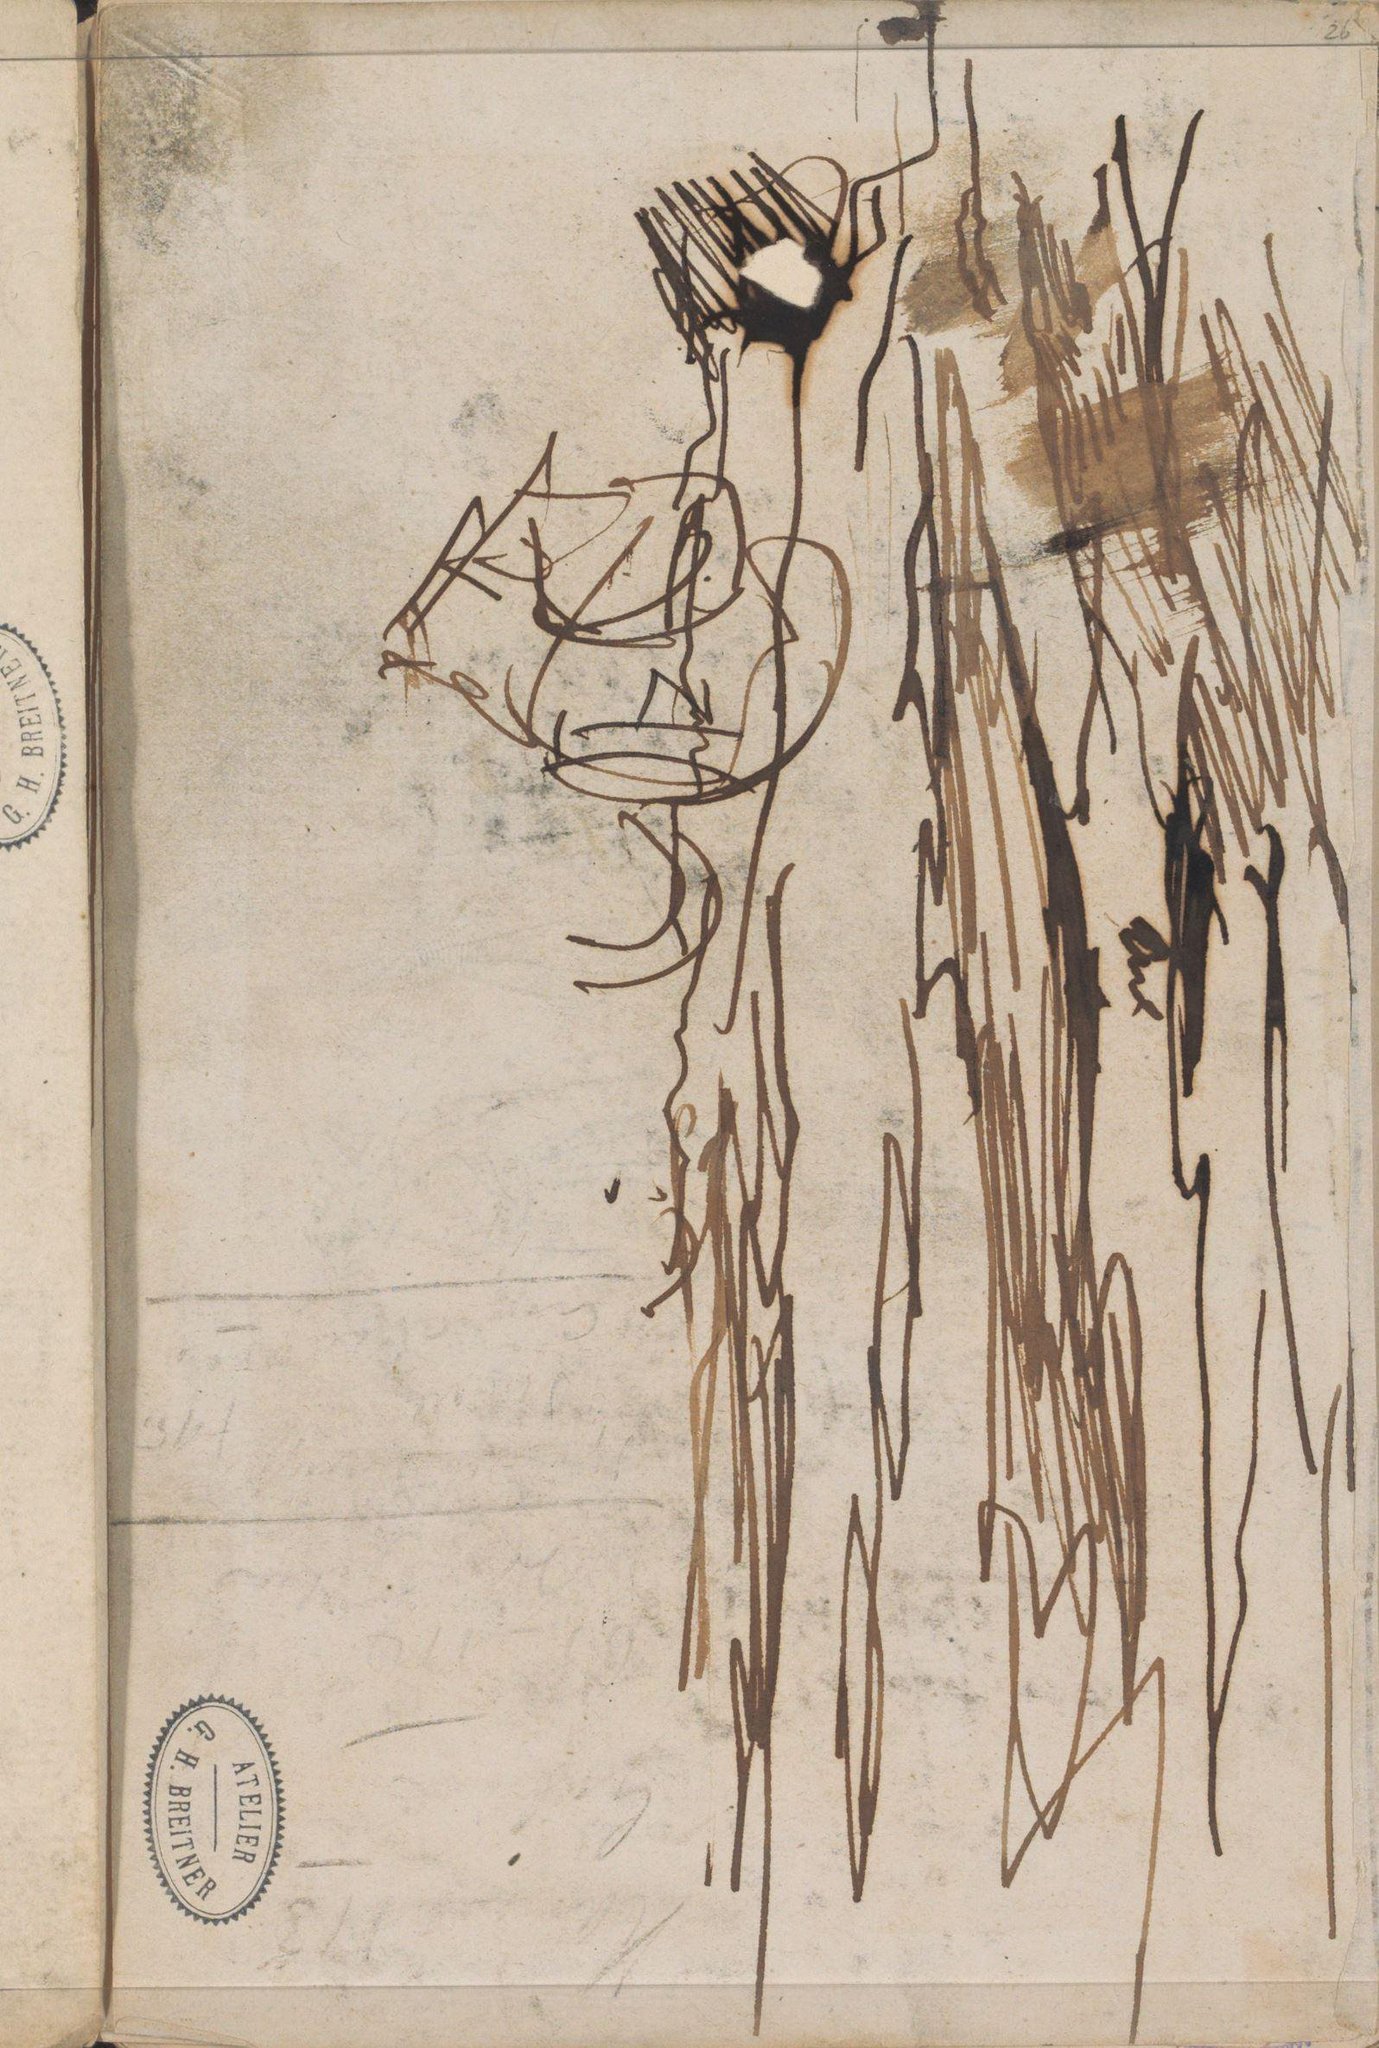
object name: sketchbook leaf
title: Landschap met wolkenlucht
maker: george hendrik breitner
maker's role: draughtsman, painter, print maker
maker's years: 1857-1923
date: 1886-1923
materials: ink, paper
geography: amsterdam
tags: landscapes, clouds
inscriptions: workshop stamp: Lugt 291d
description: Pagina 26 uit een schetsboek met 19 bladen en 9 losse tekeningen.